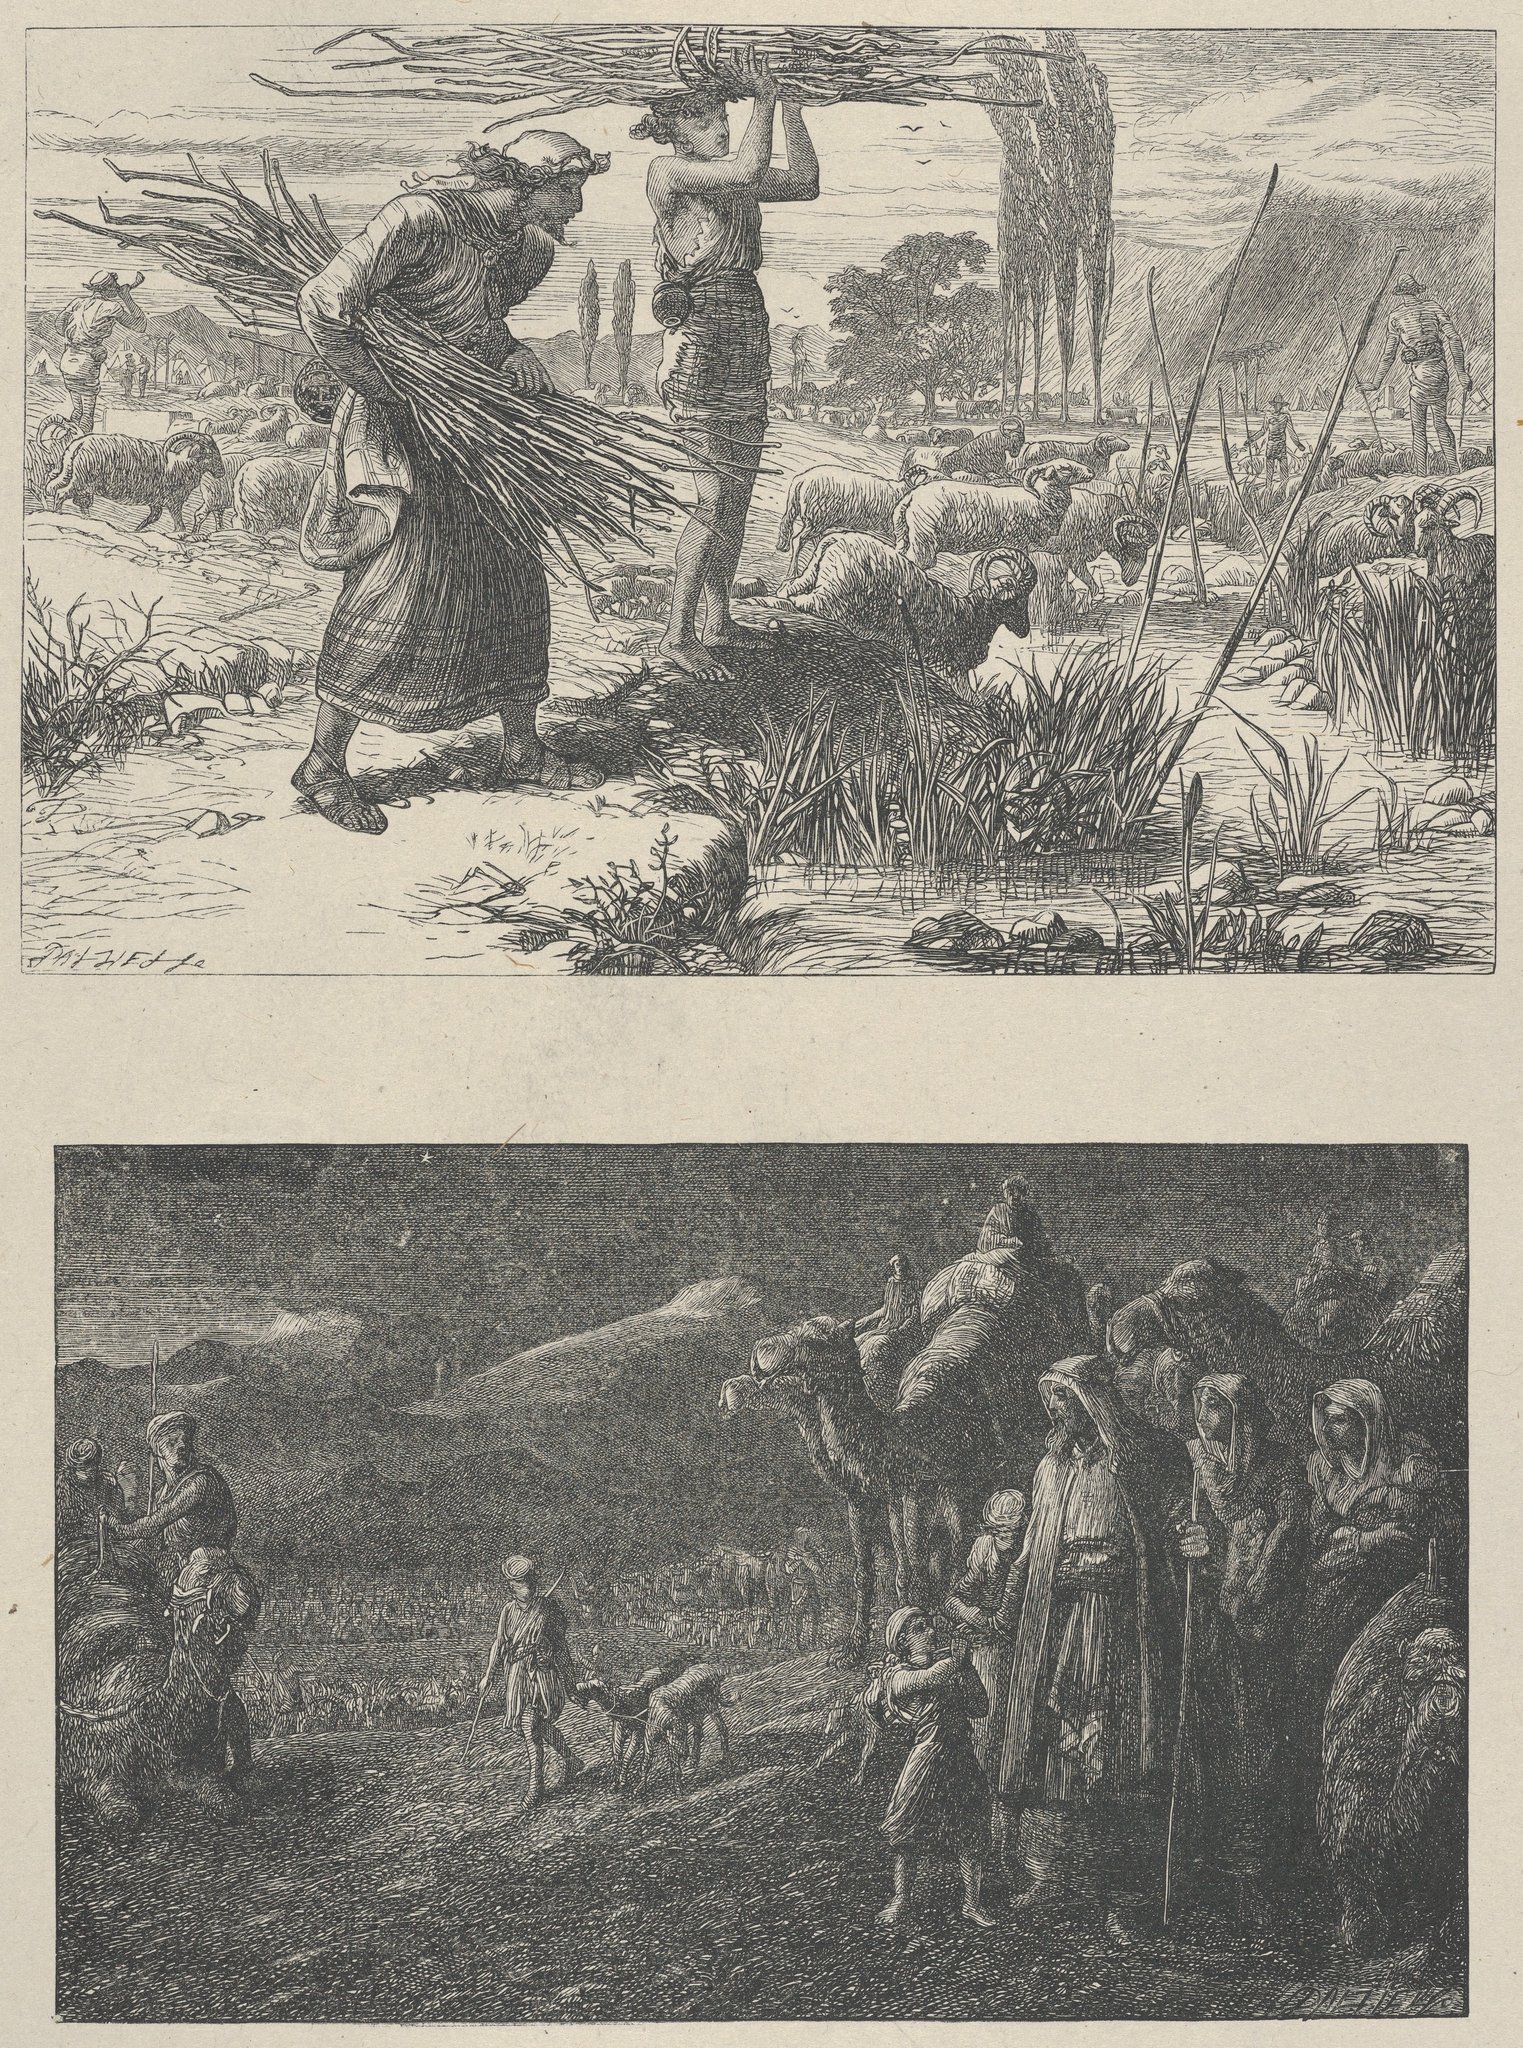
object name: print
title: Jacob and the Flocks of Laban–Jacob's Departure from Laban, from "Dalziels' Bible Gallery"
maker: thomas dalziel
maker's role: artist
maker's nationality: british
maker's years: 1823-1906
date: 1865-1881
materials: paper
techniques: engraving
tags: men,women,camels